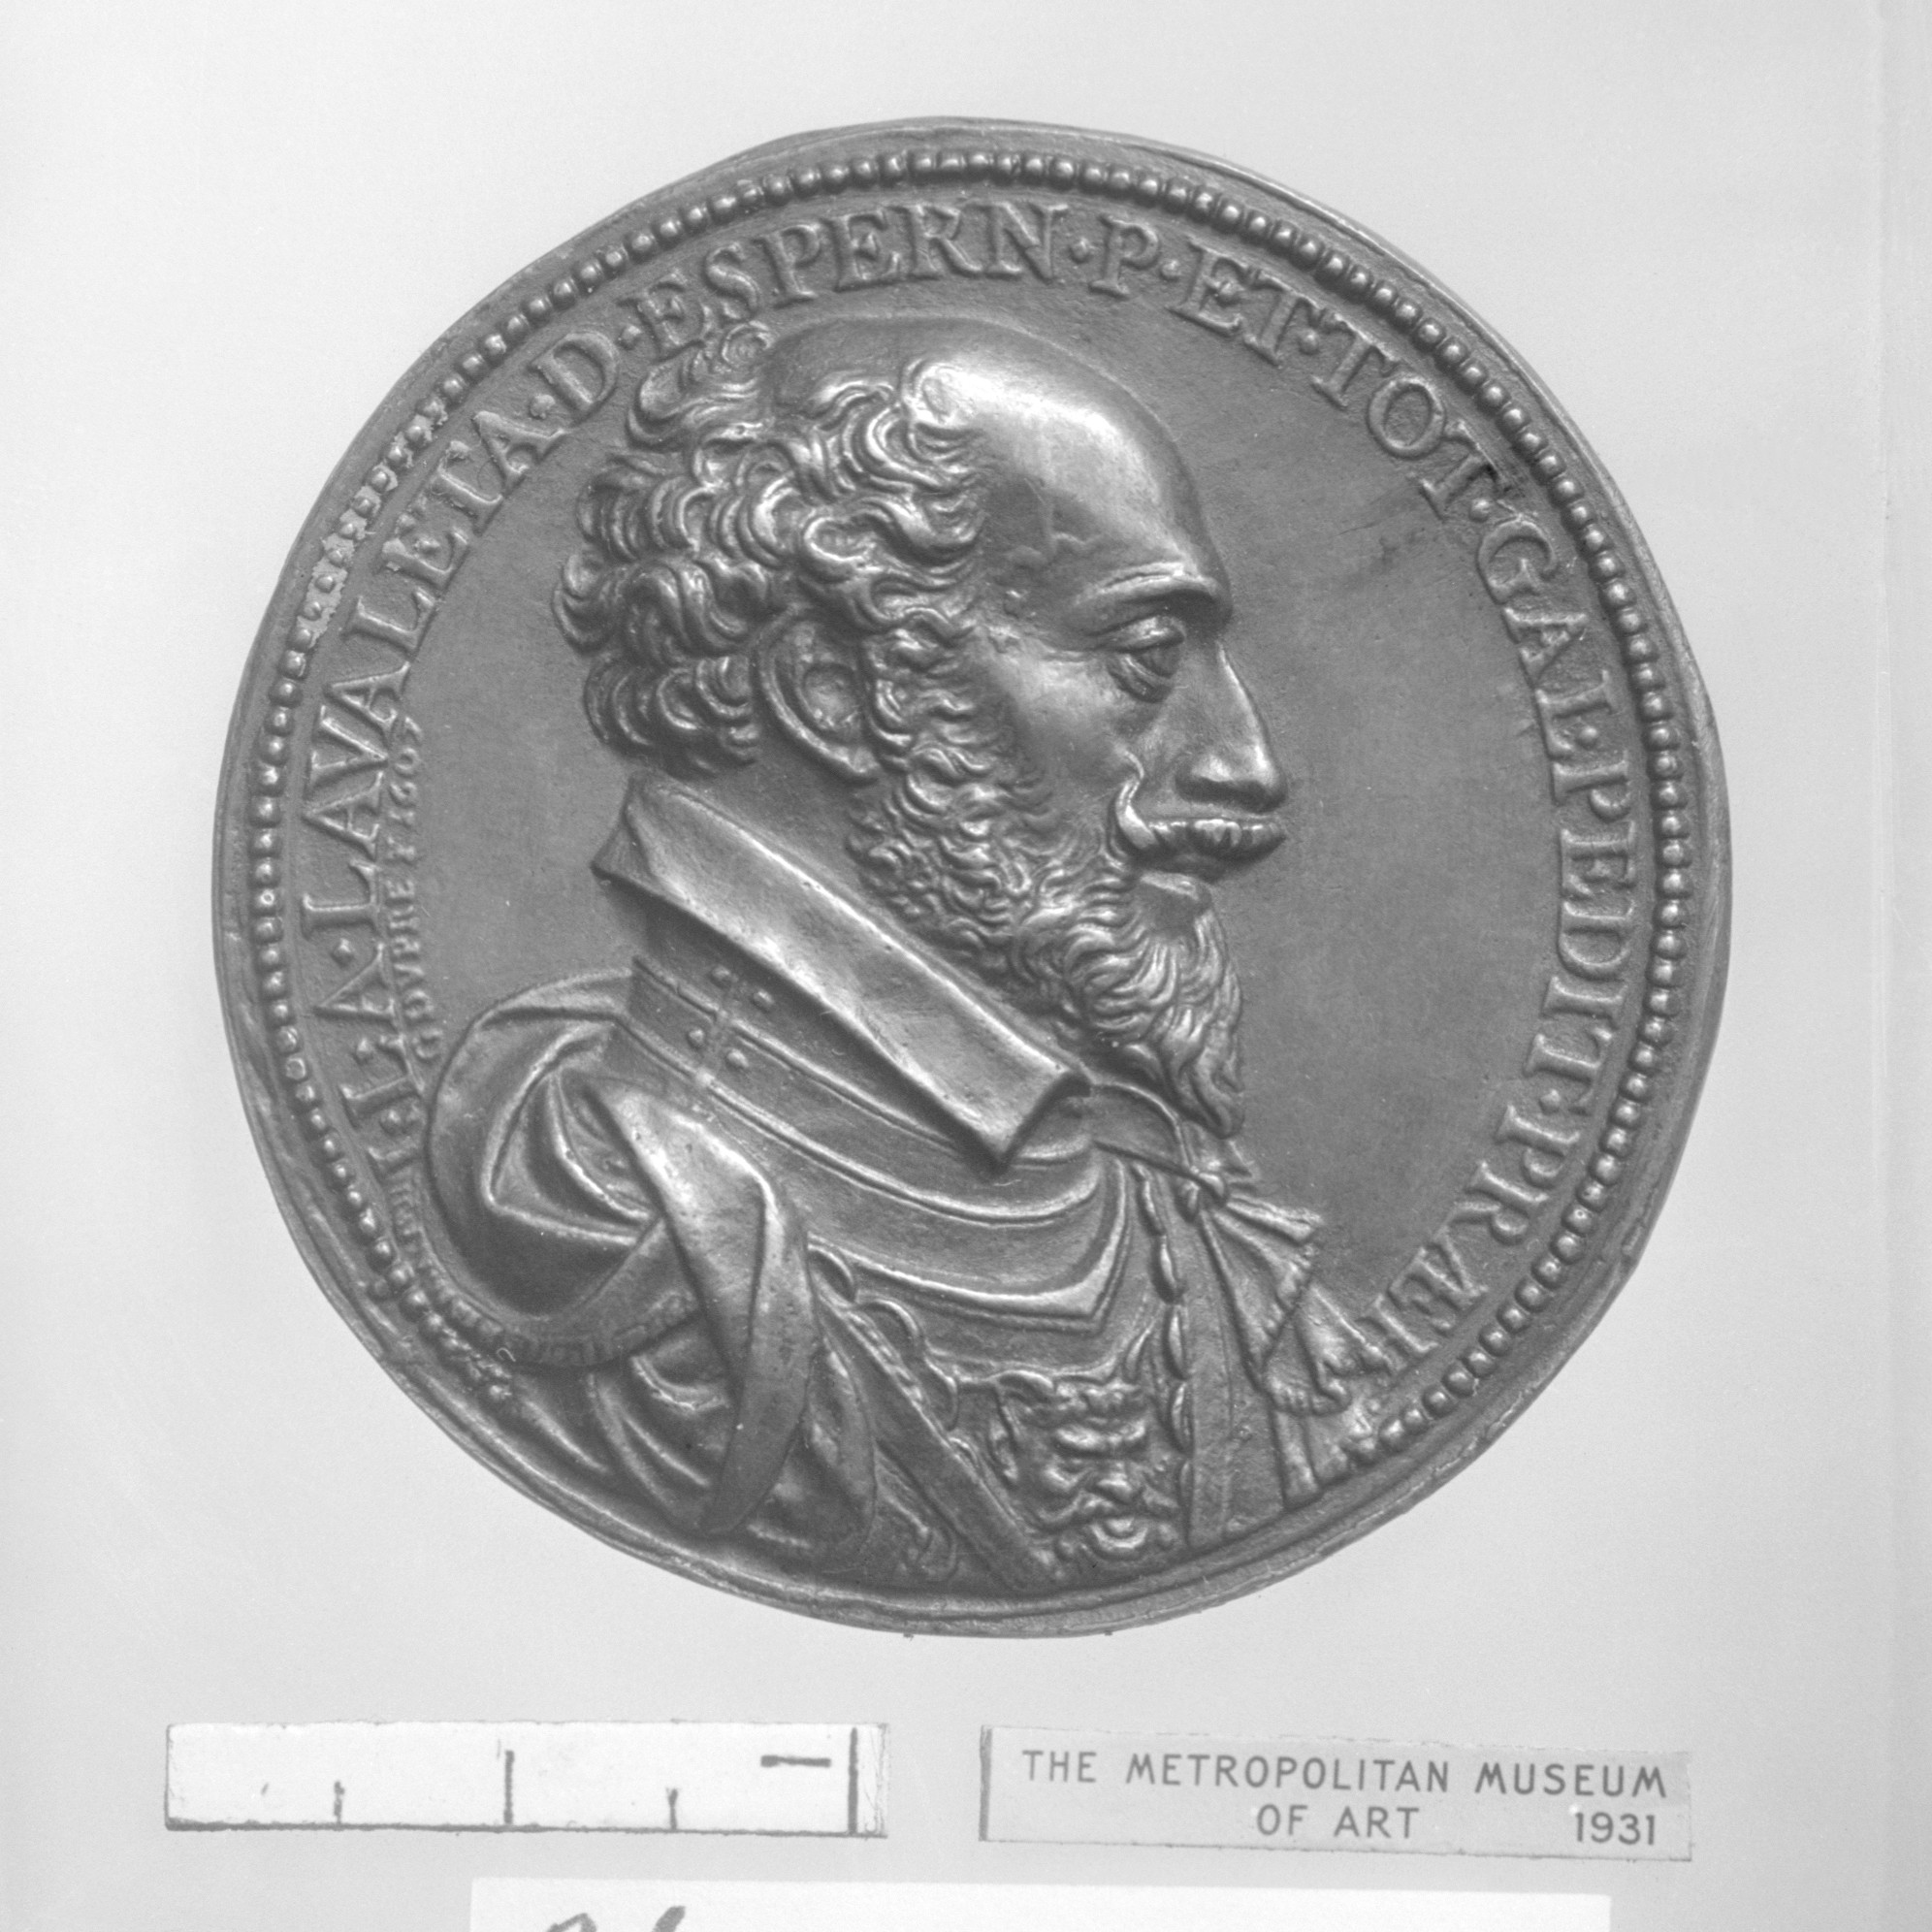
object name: medal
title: Jean-Louis de Nogaret de Lavalette, Duke of Épernon, colonel general of infantry (1554–1642)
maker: guillaume dupré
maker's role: artist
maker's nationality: french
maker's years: 1579-1640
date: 1607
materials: bronze, patina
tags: men,profiles